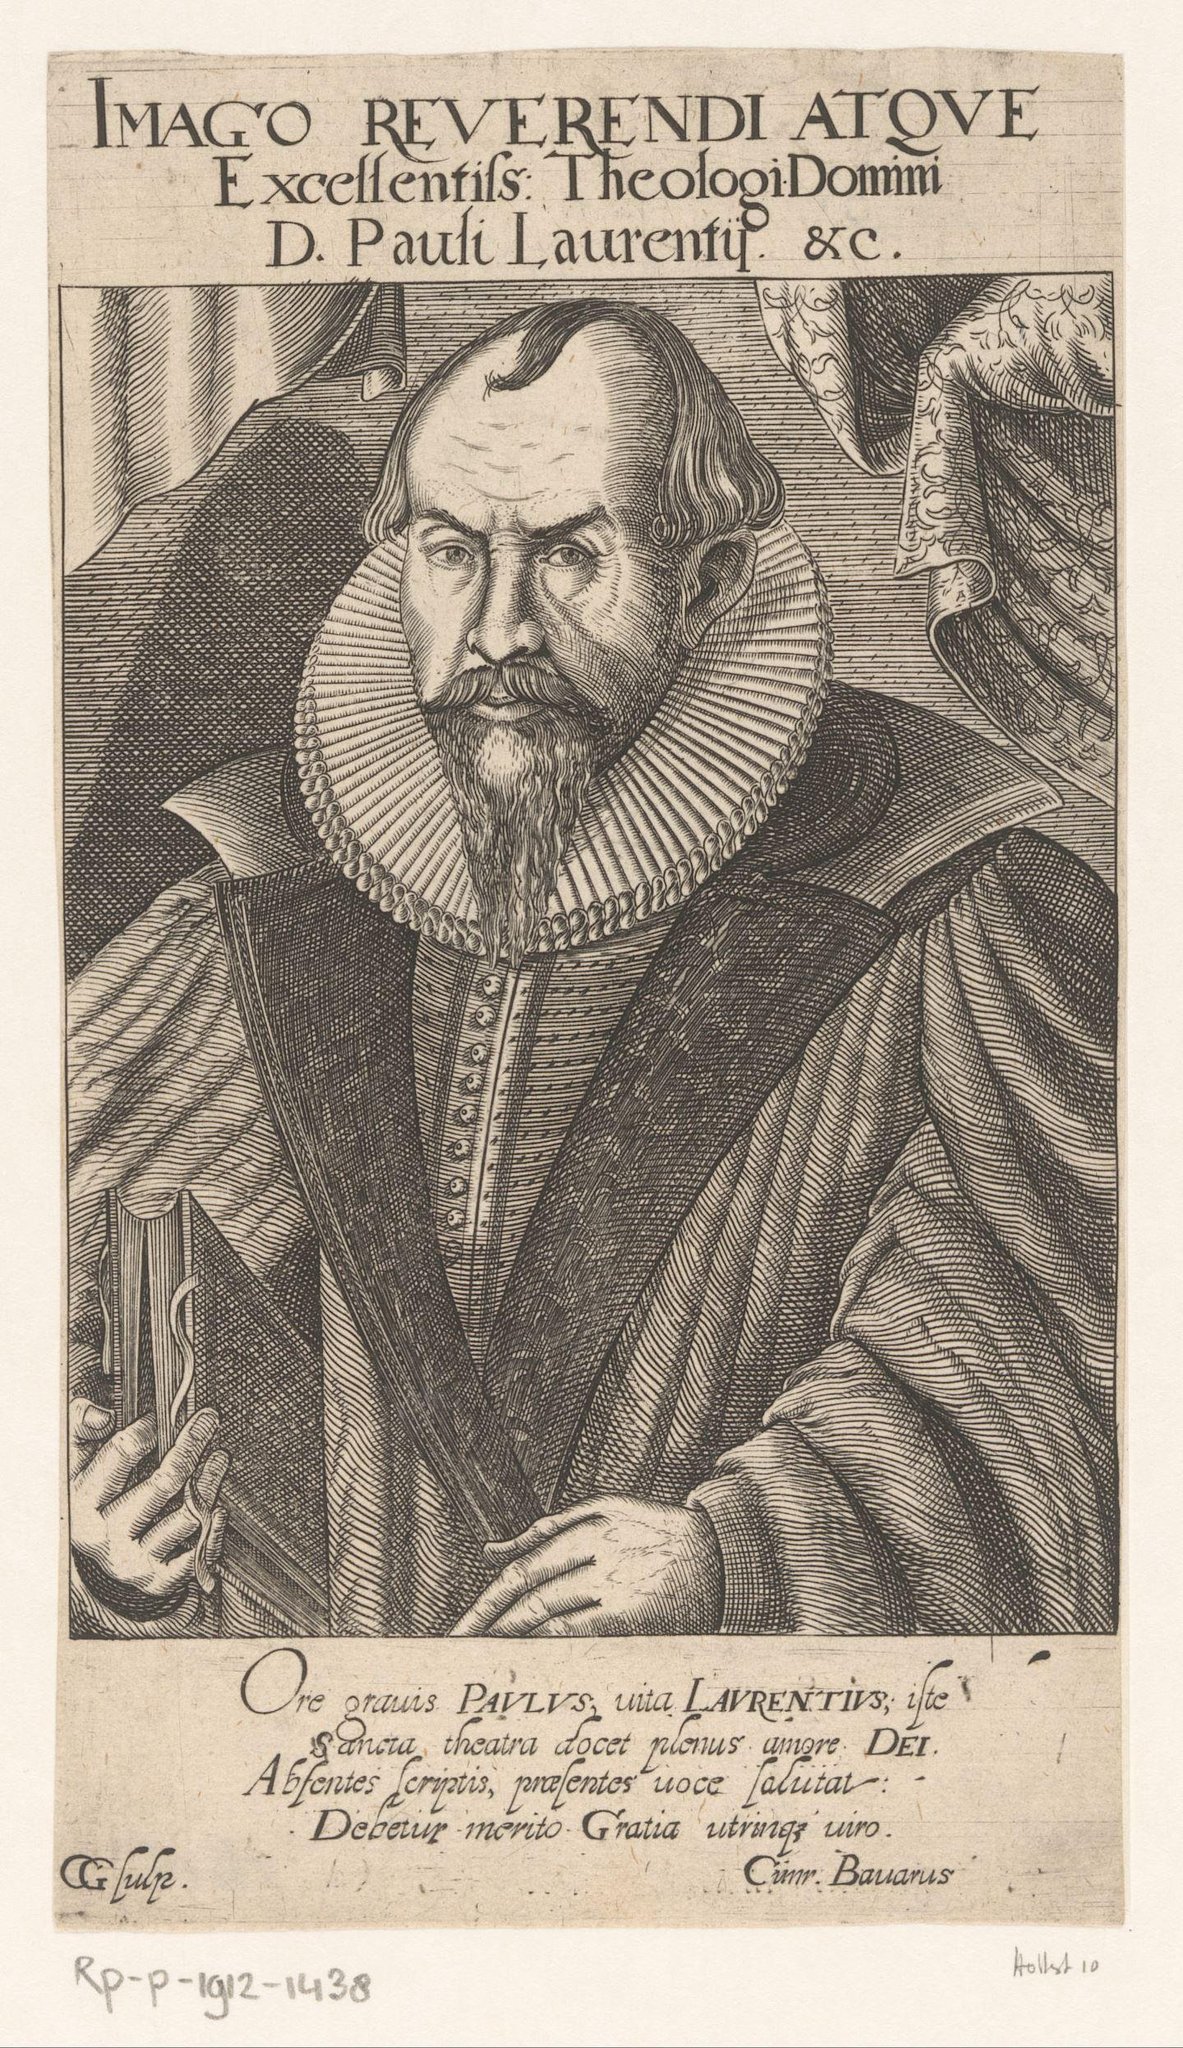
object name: print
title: Portret van Paul Laurentius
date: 1614-1630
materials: paper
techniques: engraving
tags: historical persons, book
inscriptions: collector's mark: Lugt 2228